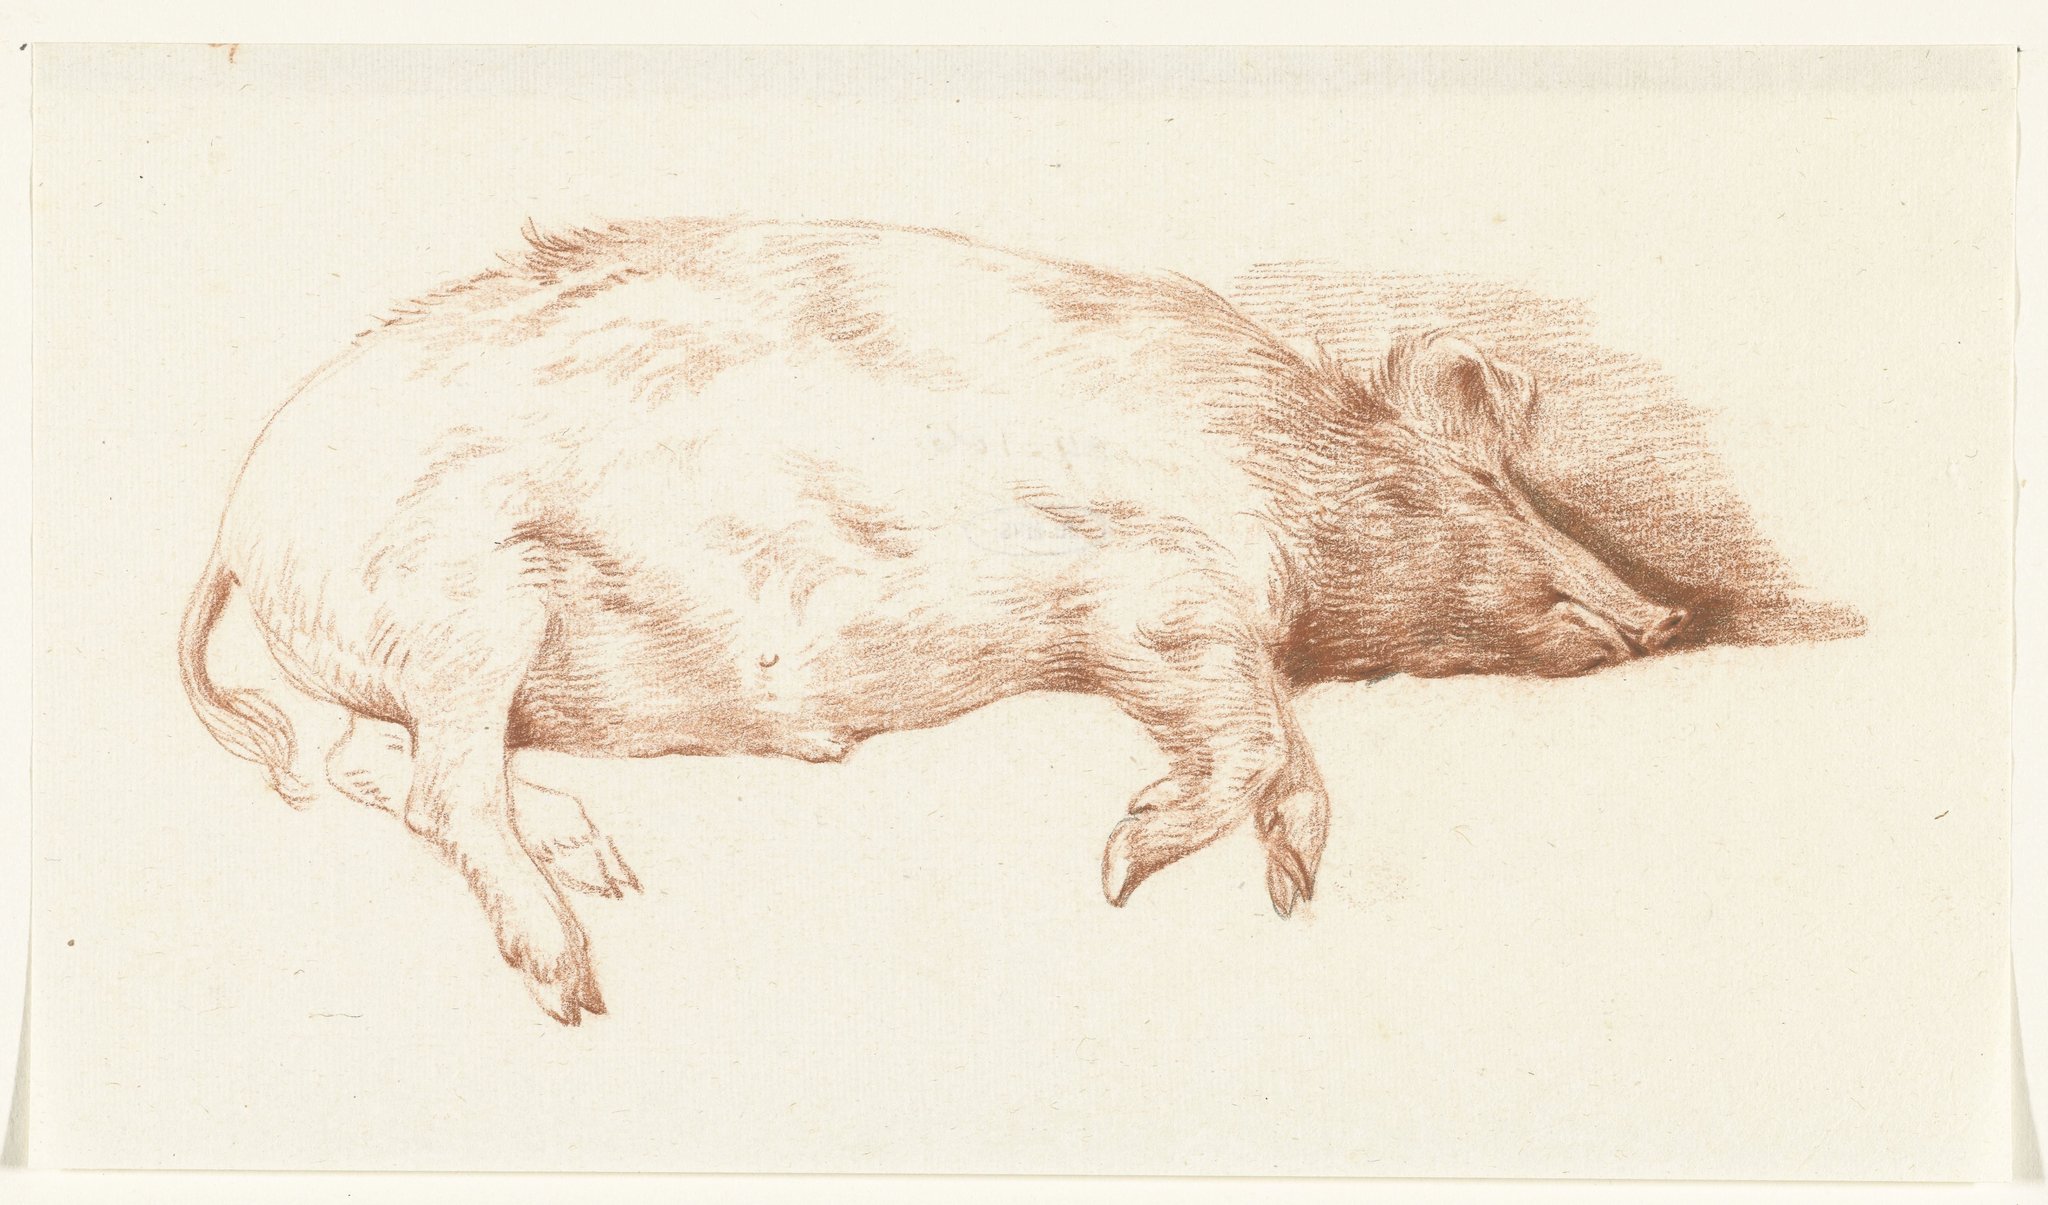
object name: drawing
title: Liggend varken, naar rechts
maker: jean bernard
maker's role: draughtsman, print maker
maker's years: 1765-1833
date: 1775-1833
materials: chalk, paper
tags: pig